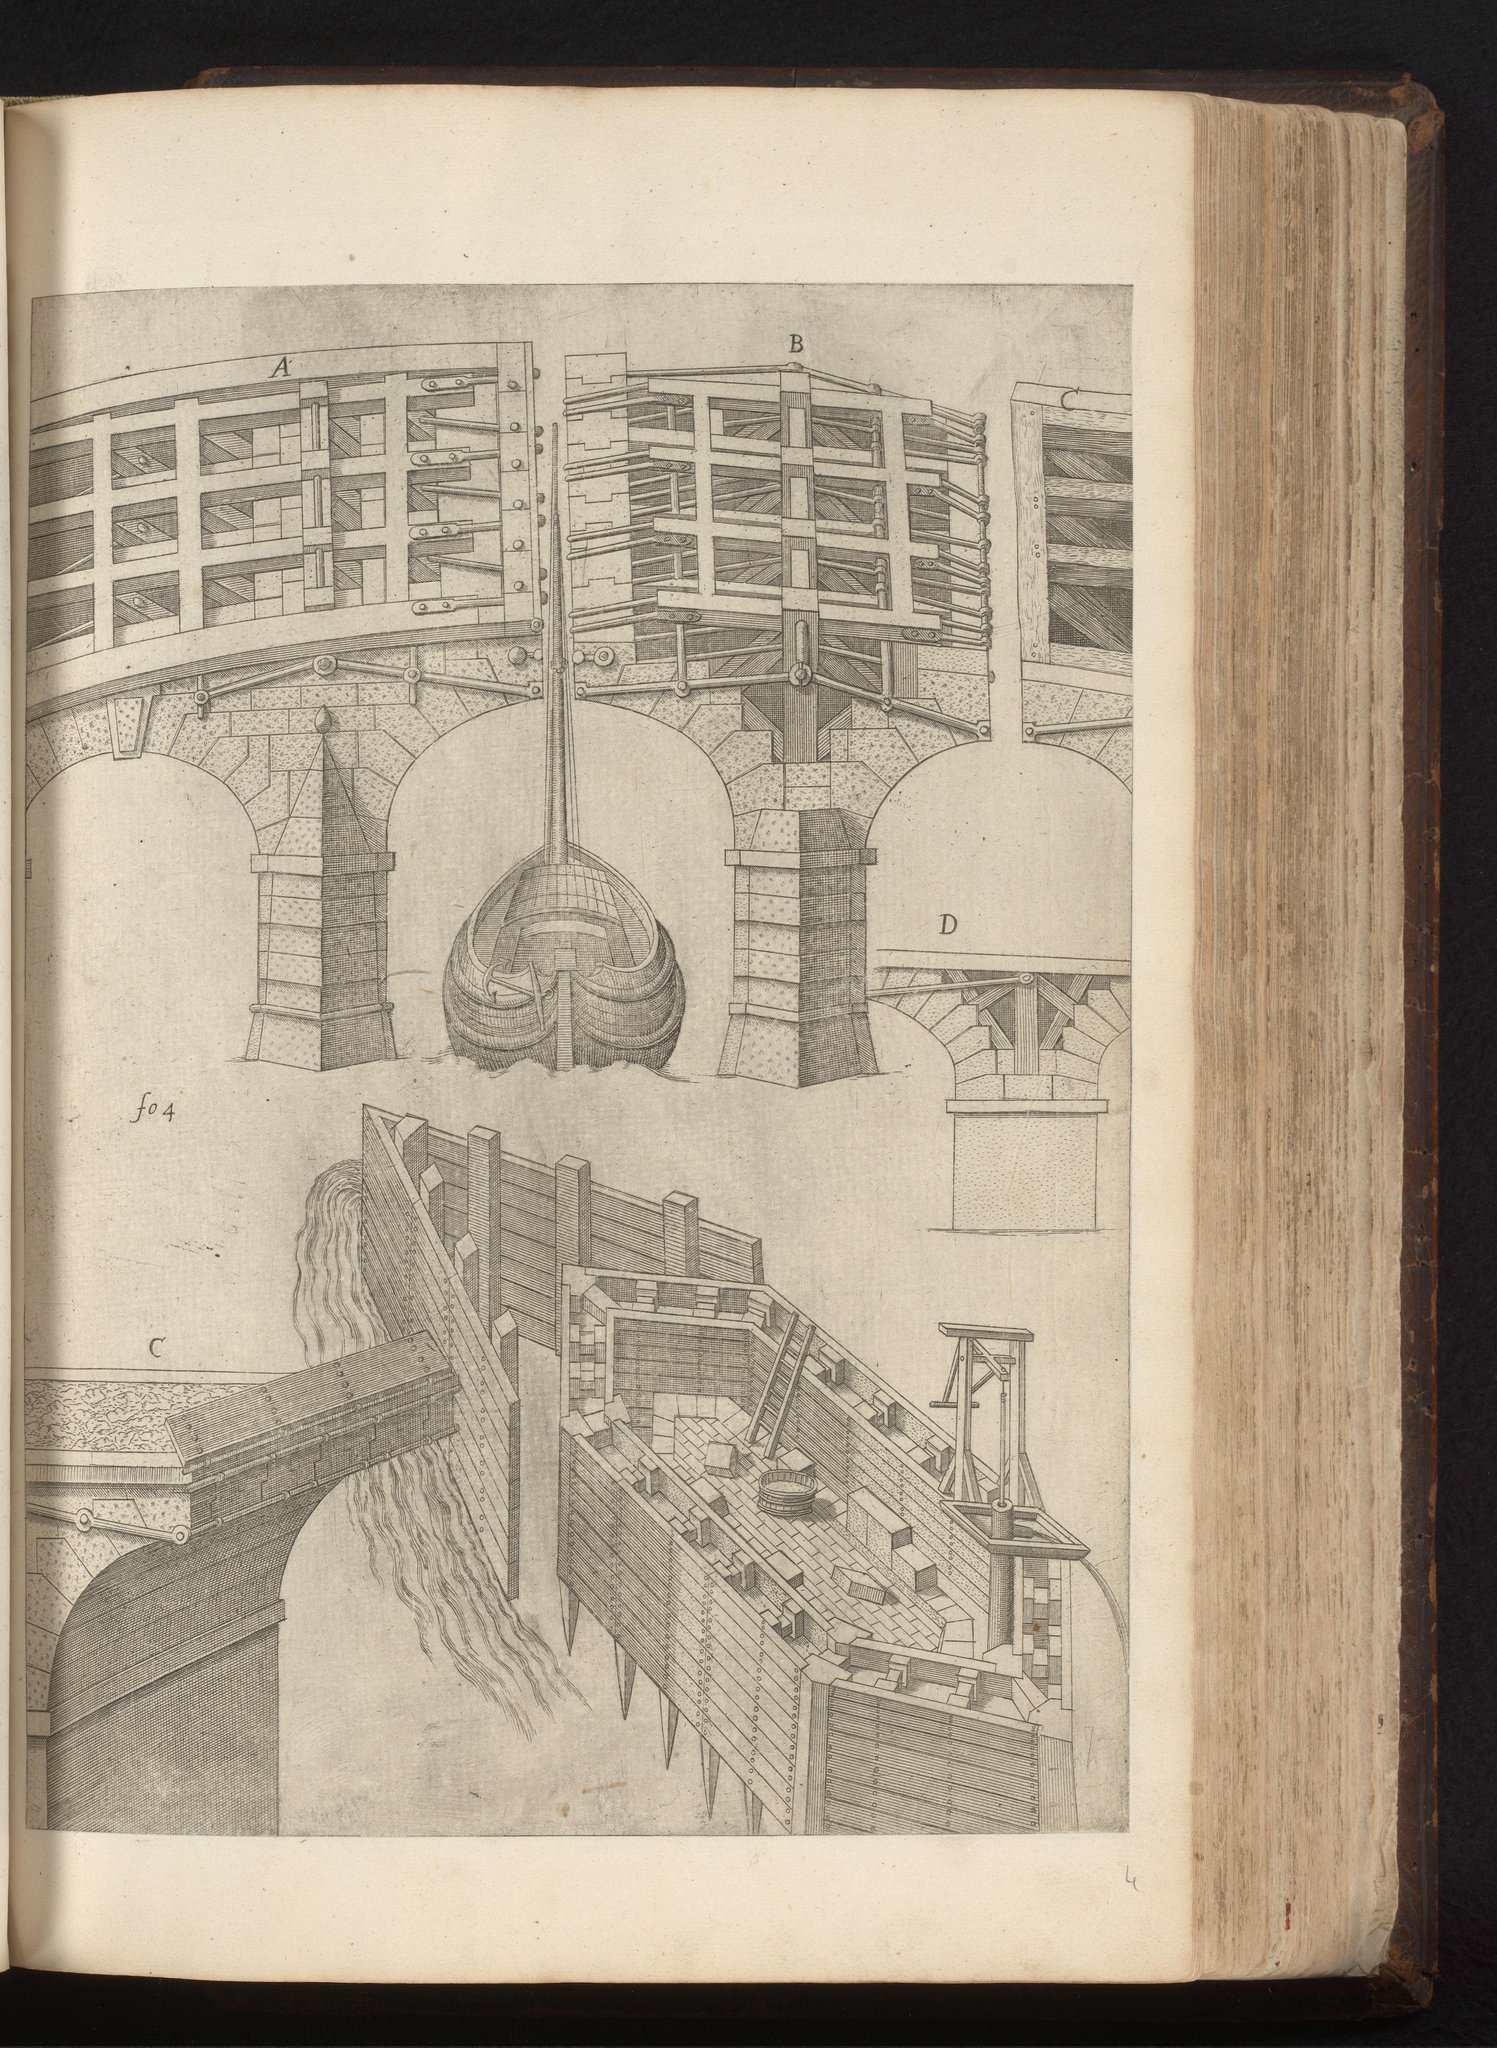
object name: book illustration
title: Waterbouwkundige werken in de Toscaanse orde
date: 1581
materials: paper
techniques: engraving, etching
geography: antwerp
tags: tuscan order ~ architecture, ships (in general), bridge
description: Prent uit: Vredeman de Vries, Hans. Architectura oder Bauung der Antiquen auss dem Vitruvius, waellches sein funff Collummen orden, (...). Antwerpen: Gerard de Jode en Gerard Smits, 1581. Prent eerder verschenen in de 1577-editie.